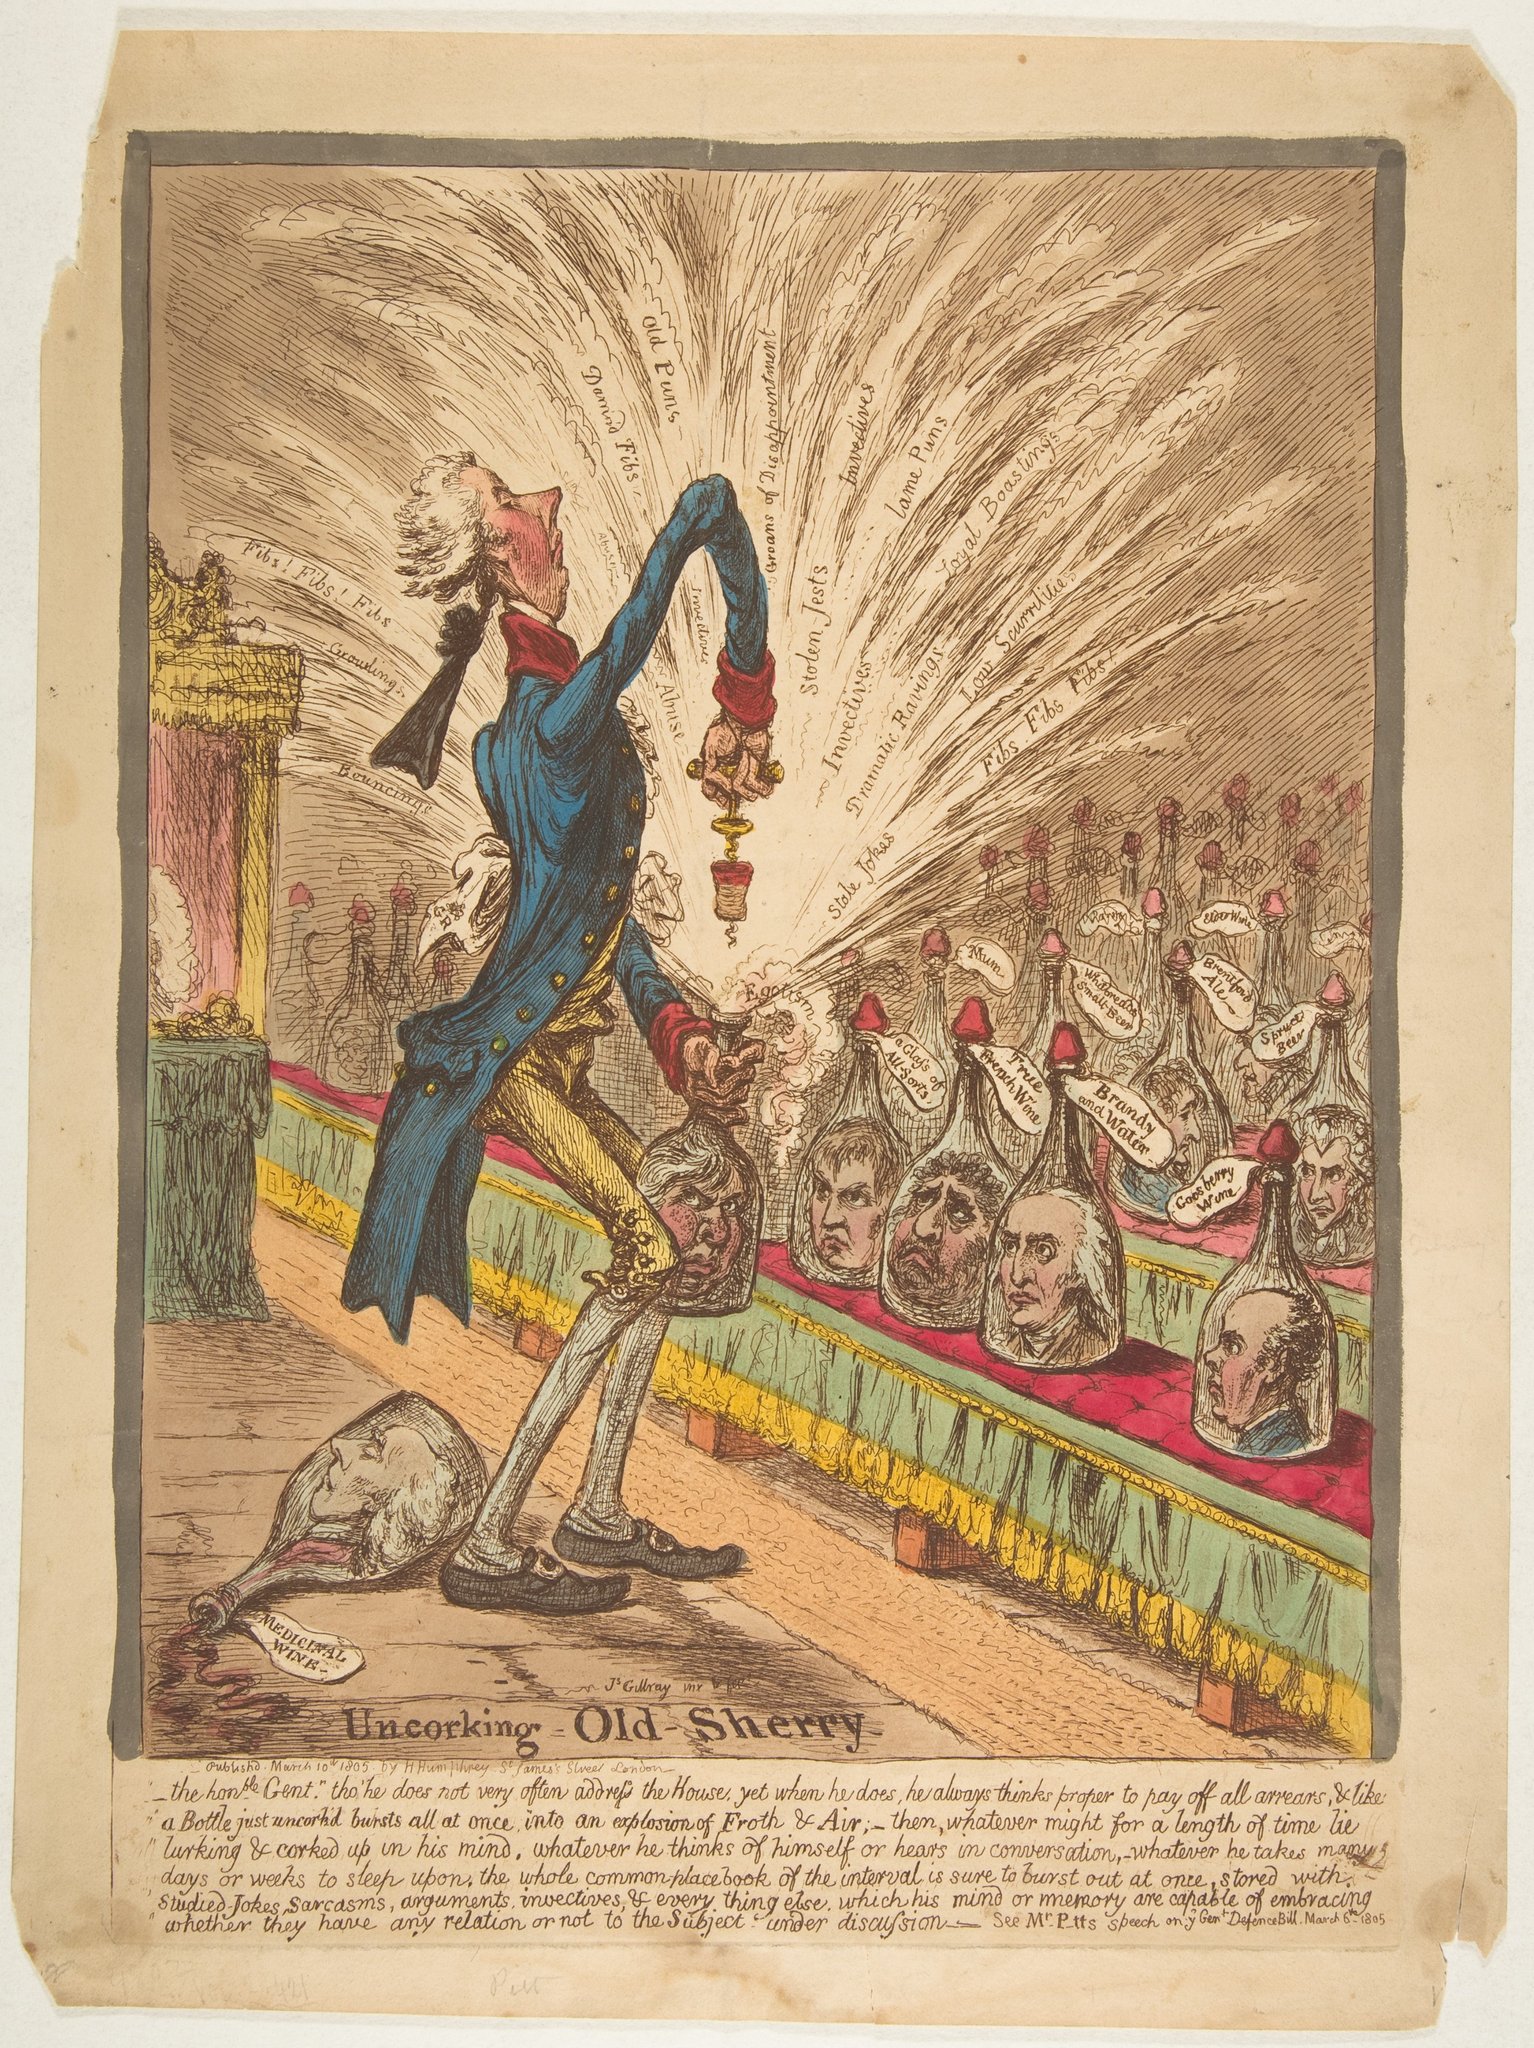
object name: print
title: Uncorking Old Sherry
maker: james gillray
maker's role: artist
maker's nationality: british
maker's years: 1756-1815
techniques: etching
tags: satire,men,politics